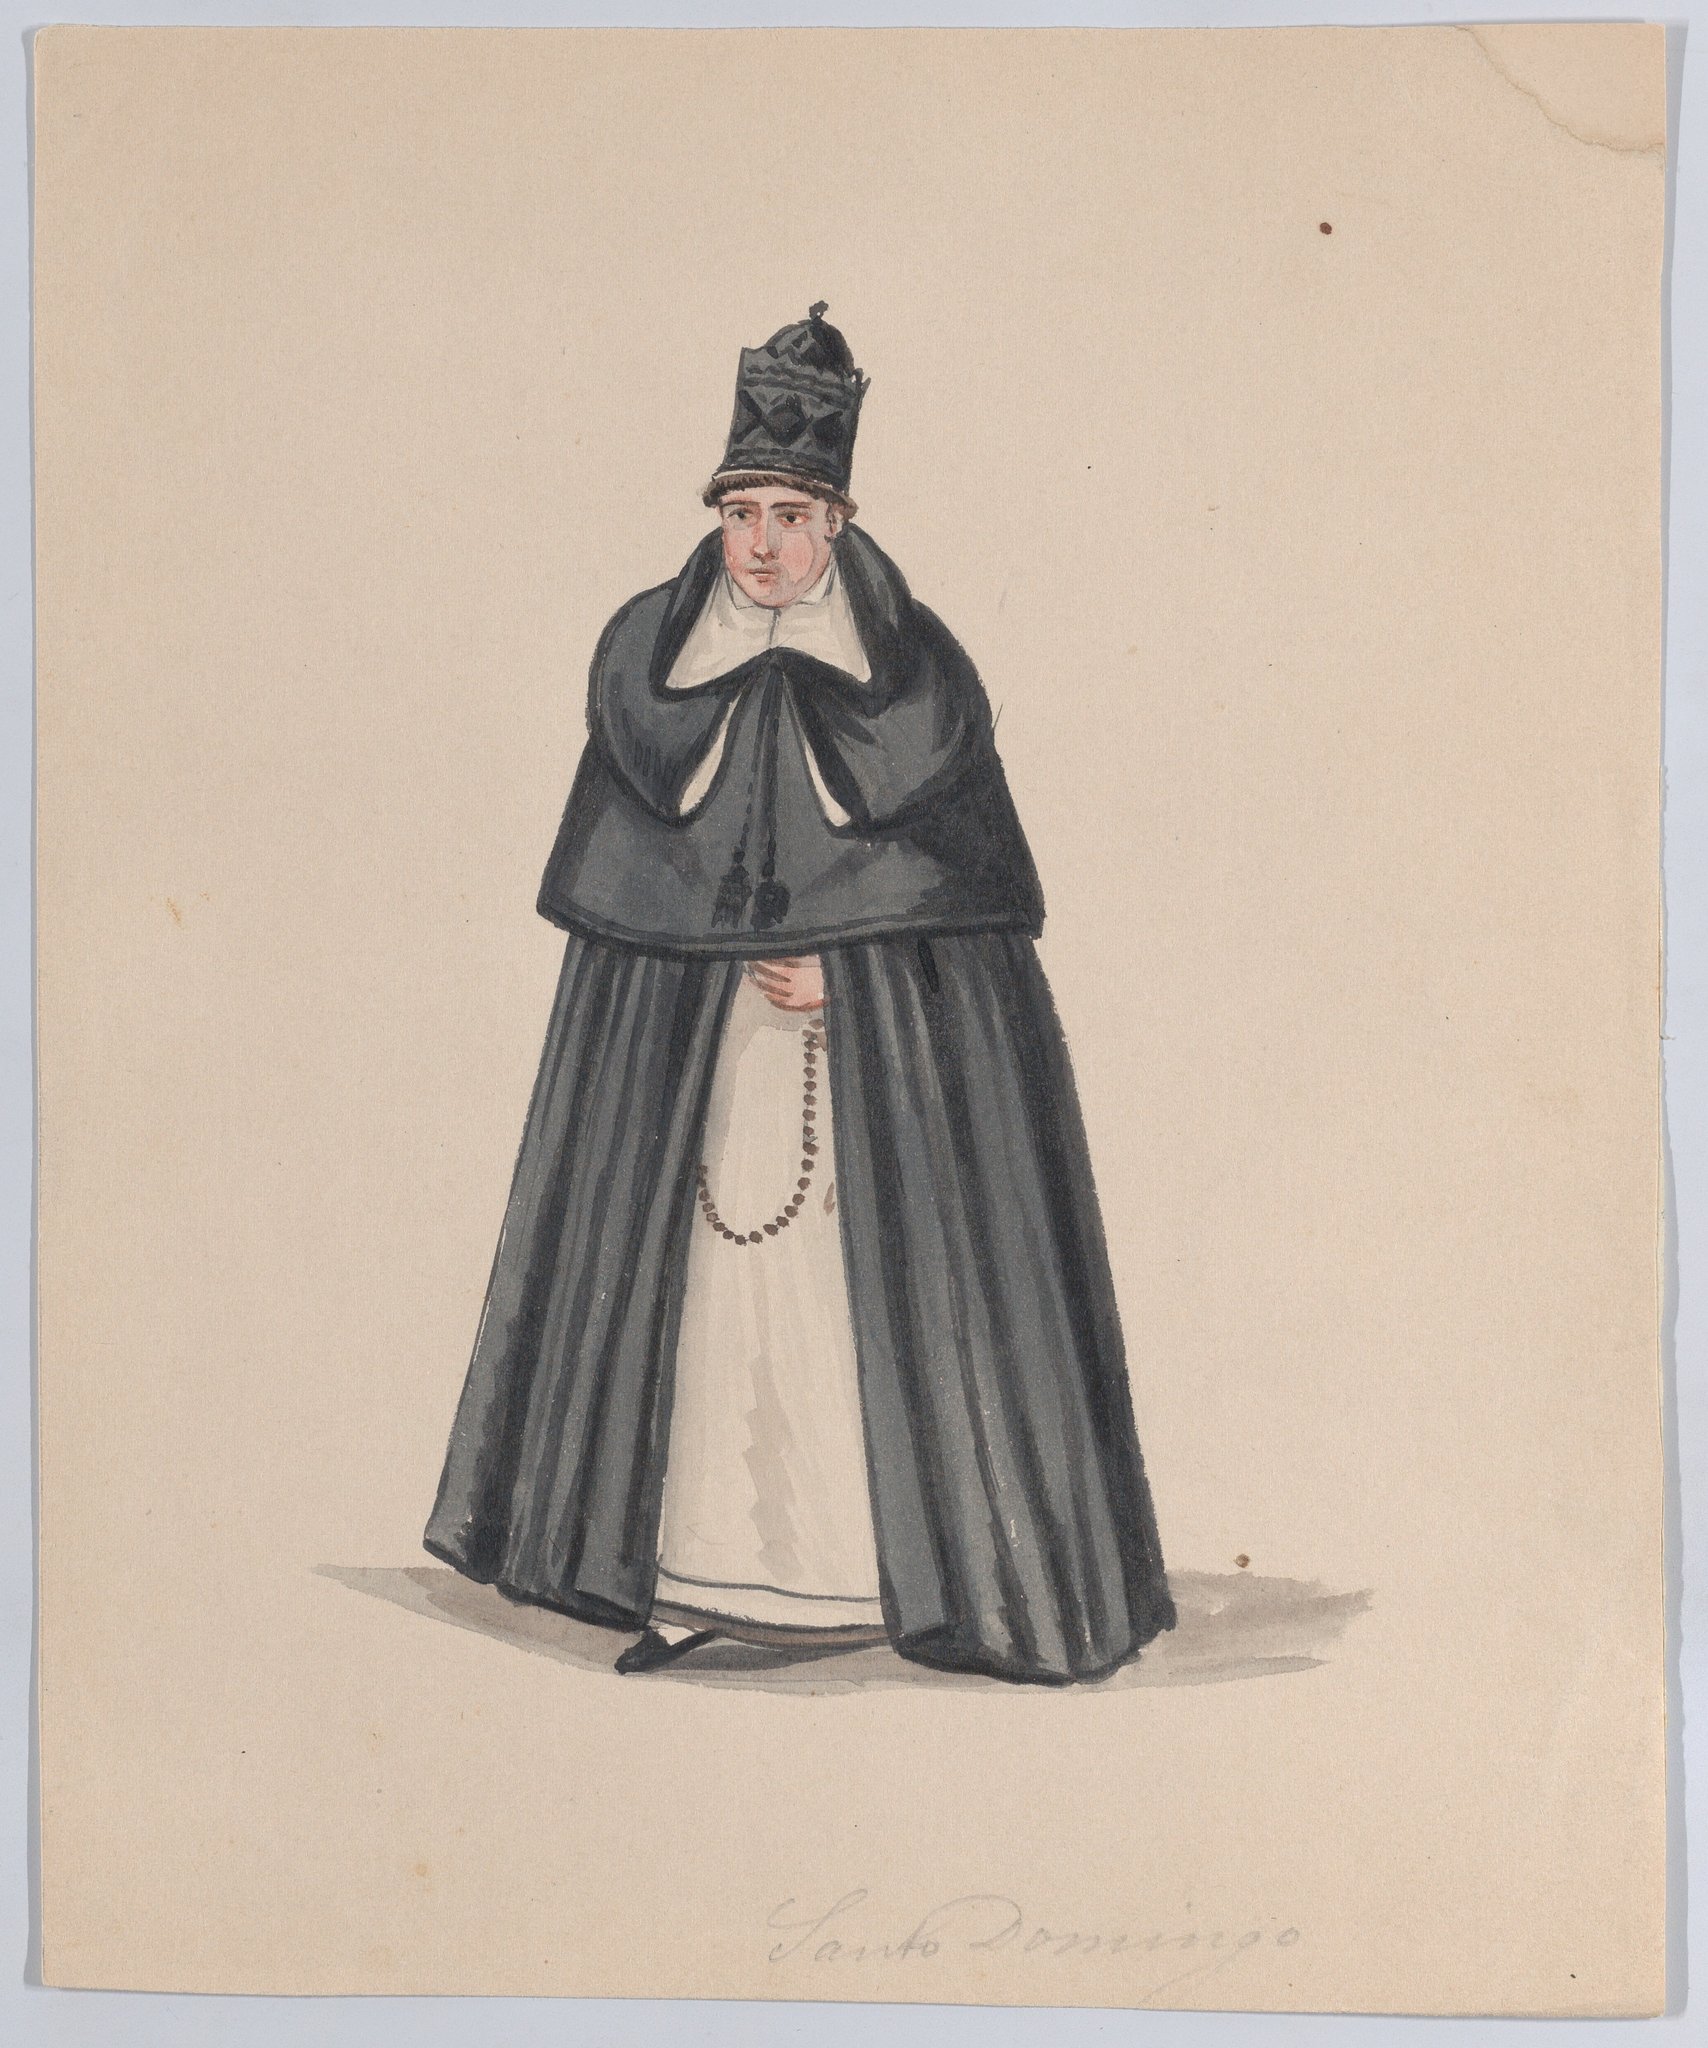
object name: drawing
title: A priest from the order of Santo Domingo (Saint Dominic), from a group of drawings depicting Peruvian dress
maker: francisco (pancho) fierro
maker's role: artist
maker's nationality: african peruvian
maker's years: 1807-1879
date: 1848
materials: watercolor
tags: men,women